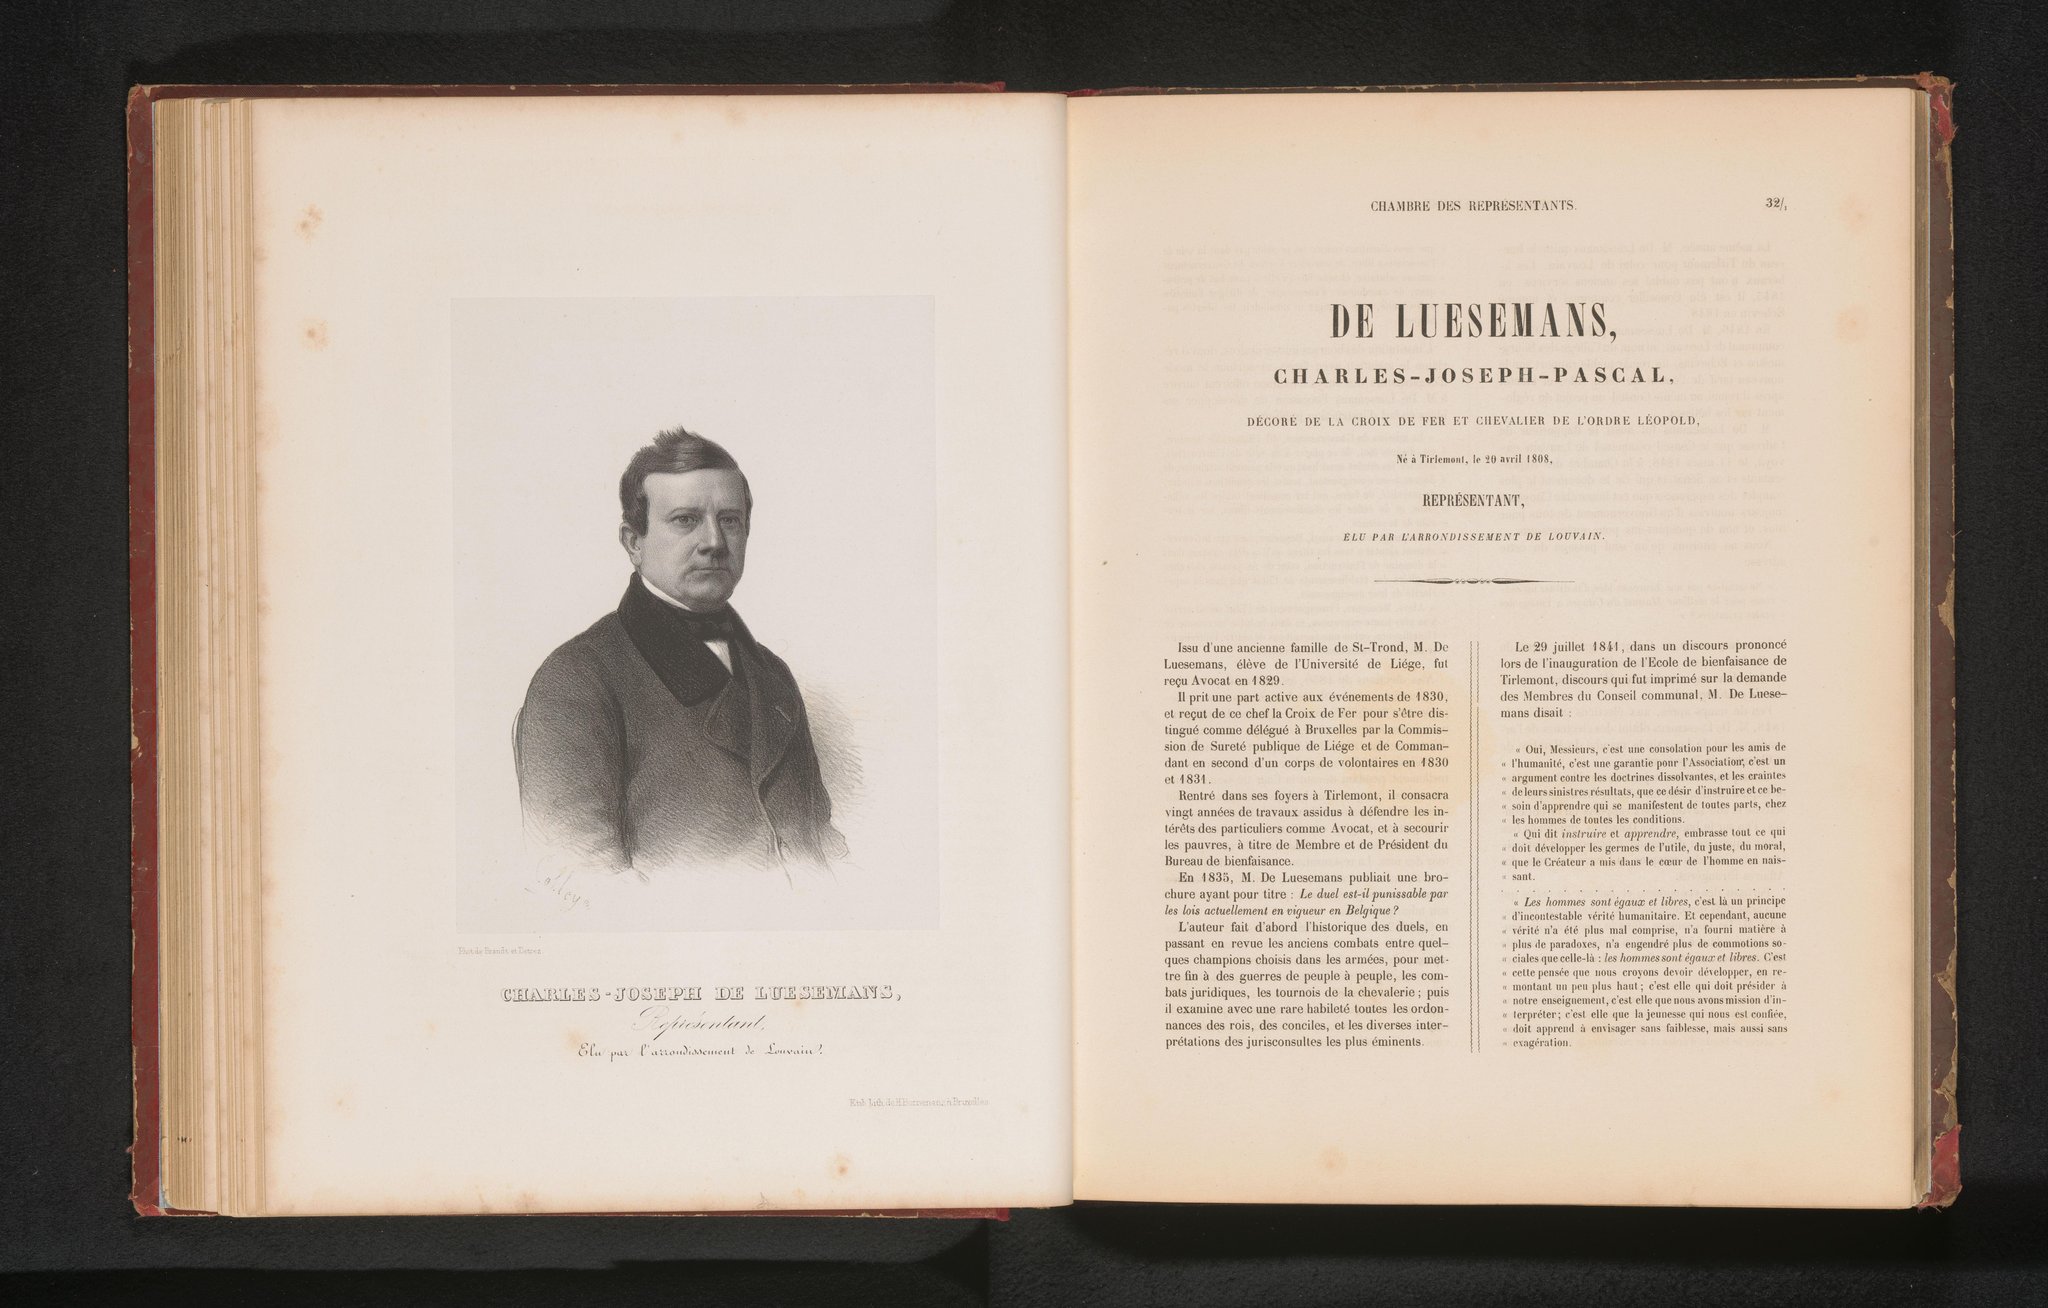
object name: print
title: Reproductie van een foto van een portret van Charles de Luesemans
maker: henri borremans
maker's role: print maker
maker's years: 1800-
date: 1853-1858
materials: paper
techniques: lithograph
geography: brussels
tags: politician, historical persons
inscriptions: inscription: ‘Représentant,/ Elu par l'arrondissement de Louvain.’